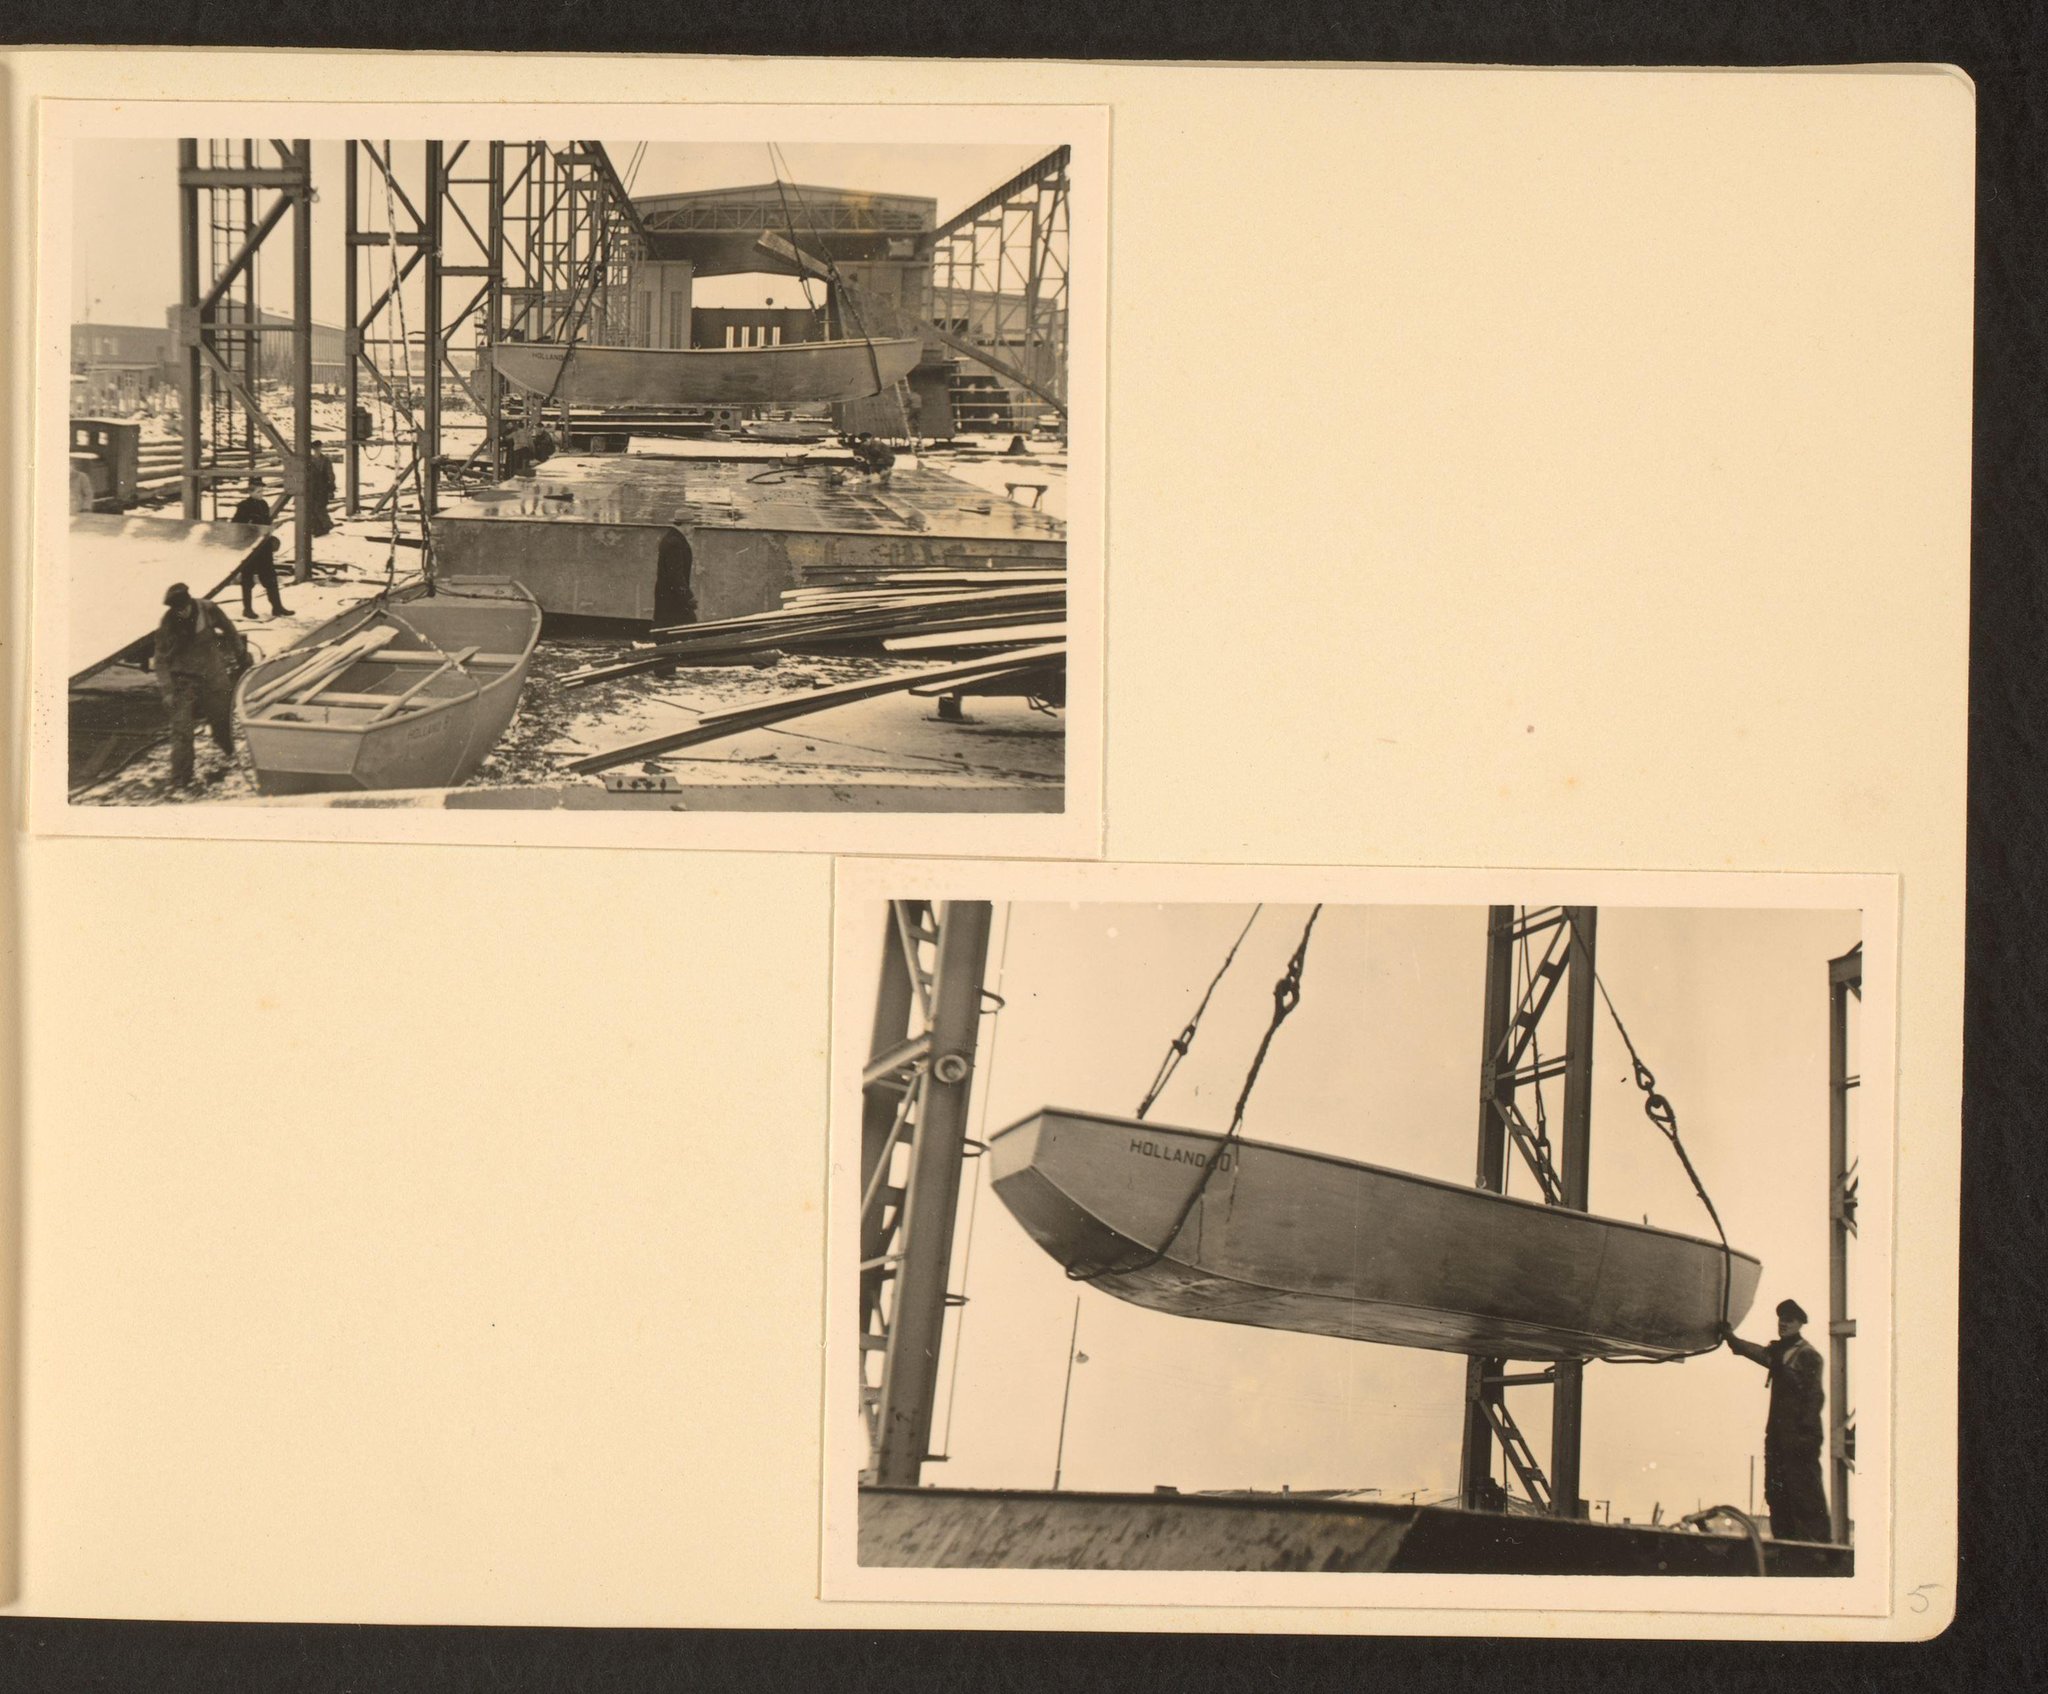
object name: photograph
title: Metalen sloepen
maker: Anonymous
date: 1902-1953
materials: paper, photographic support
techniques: gelatin silver print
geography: emden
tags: building a ship, ship under construction, rowing-boat, canoe, etc., pier, quay, wharf, north sea flood of 1953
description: Albumblad met twee foto's van de metalen sloepen op het terrein van de werf van Nordseewerke Emden. Onderdeel van het fotoalbum 'Emden hilft Holland'.